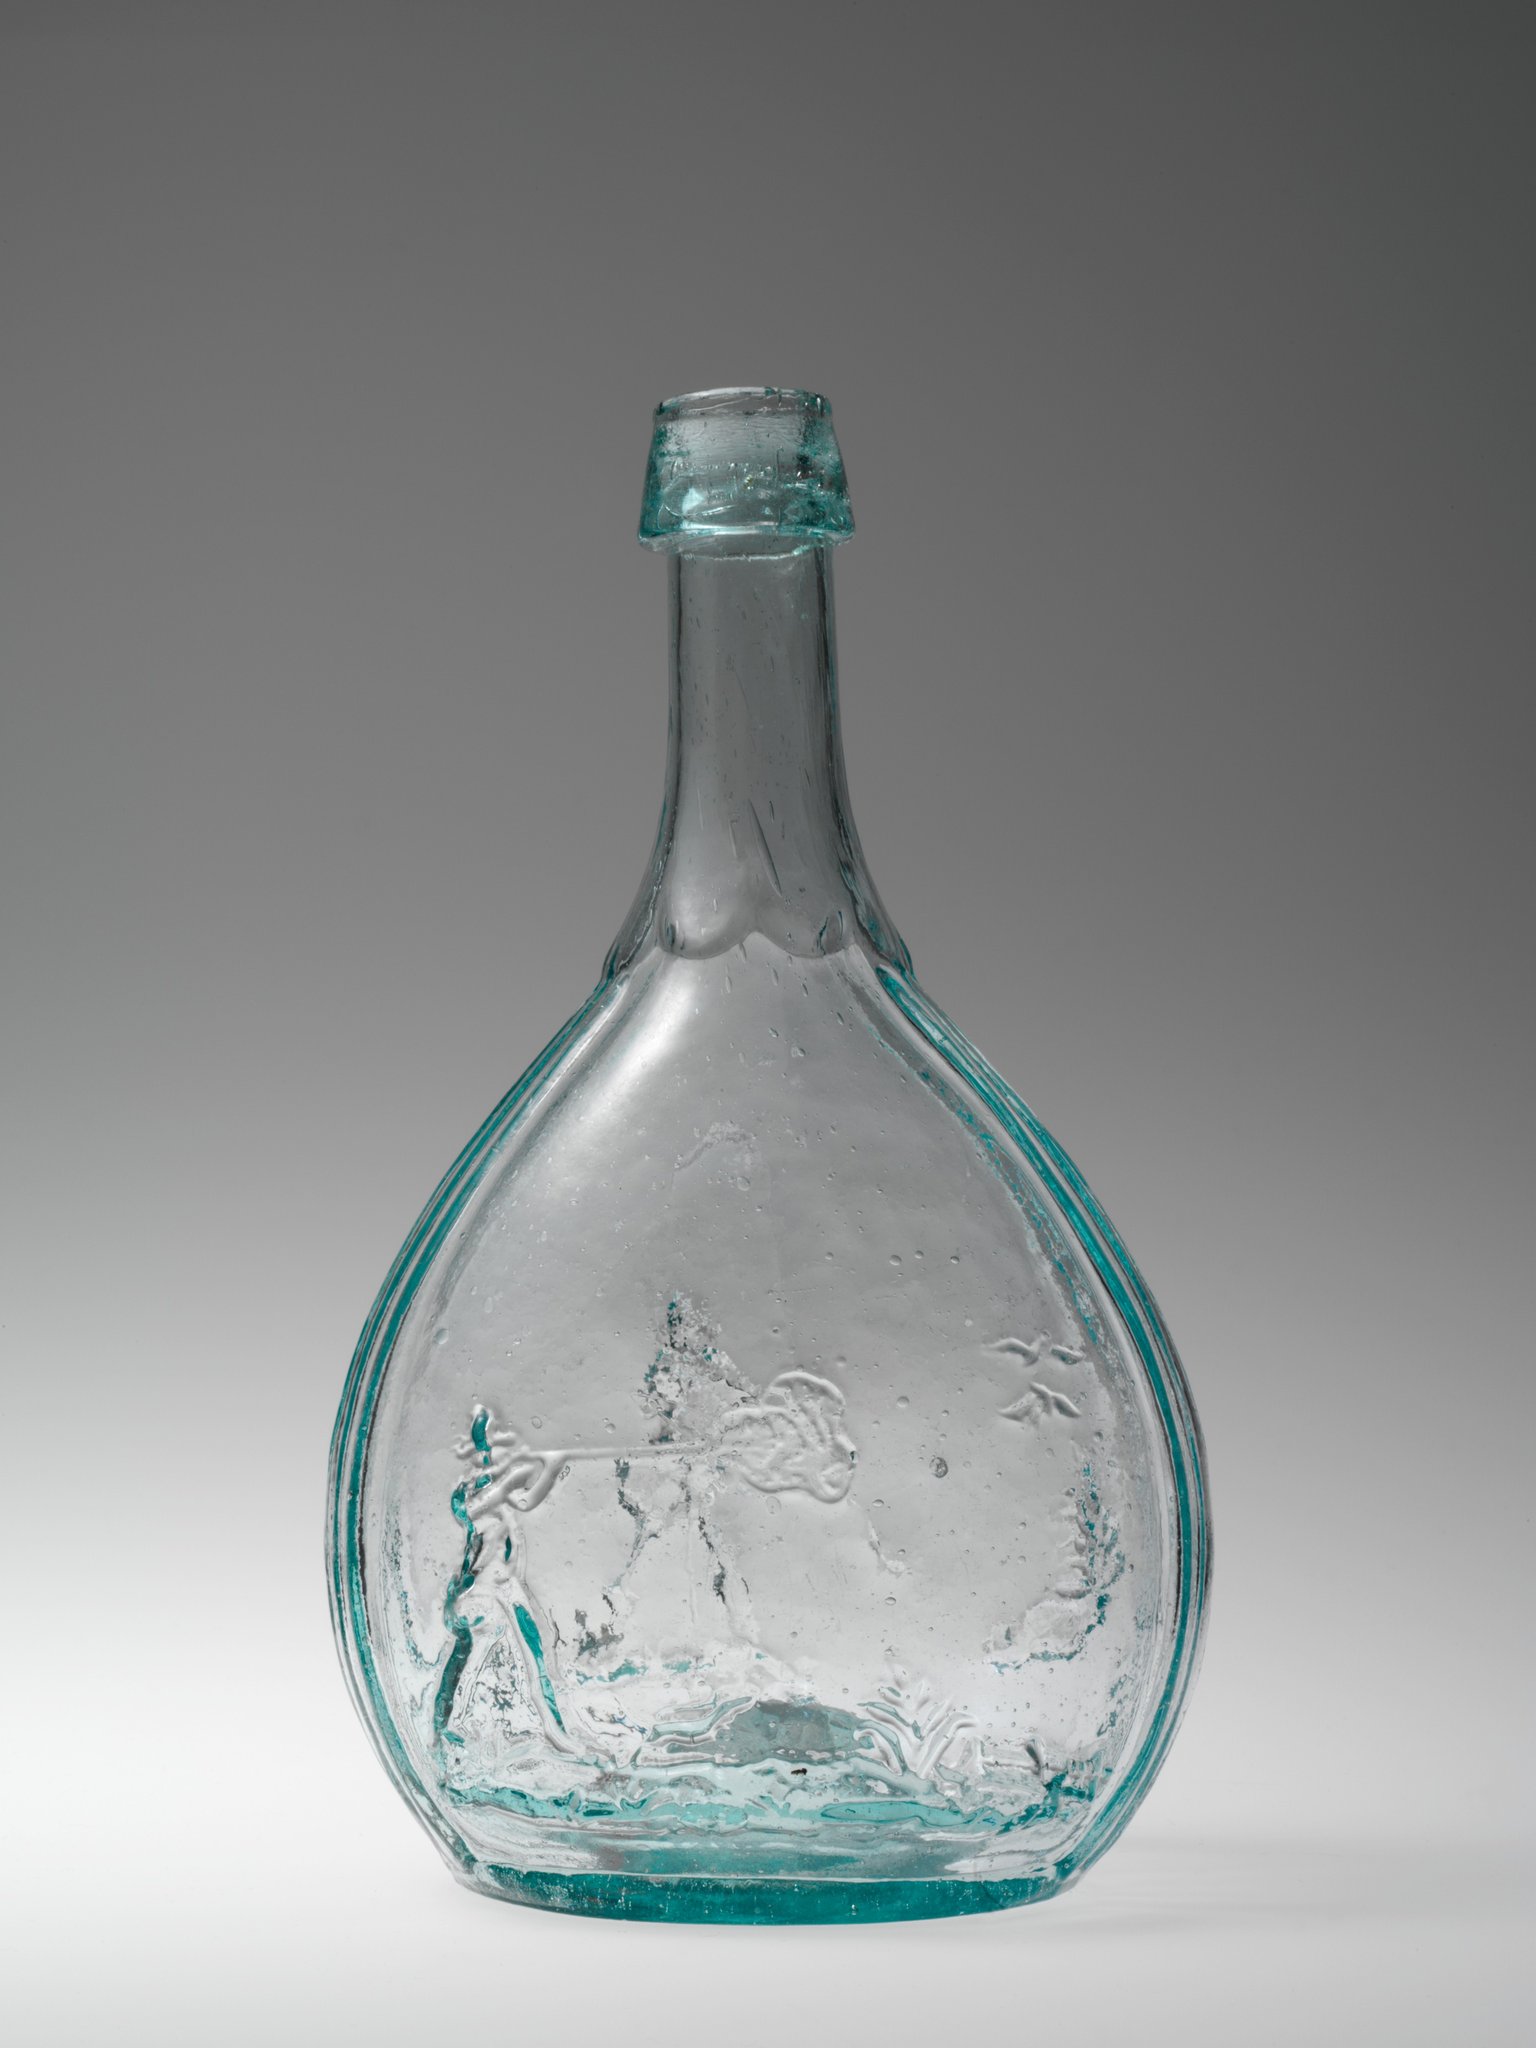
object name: bottle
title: Figured bottle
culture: american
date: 1850-1860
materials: glass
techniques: glassblowing, molding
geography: united states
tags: men,hunting